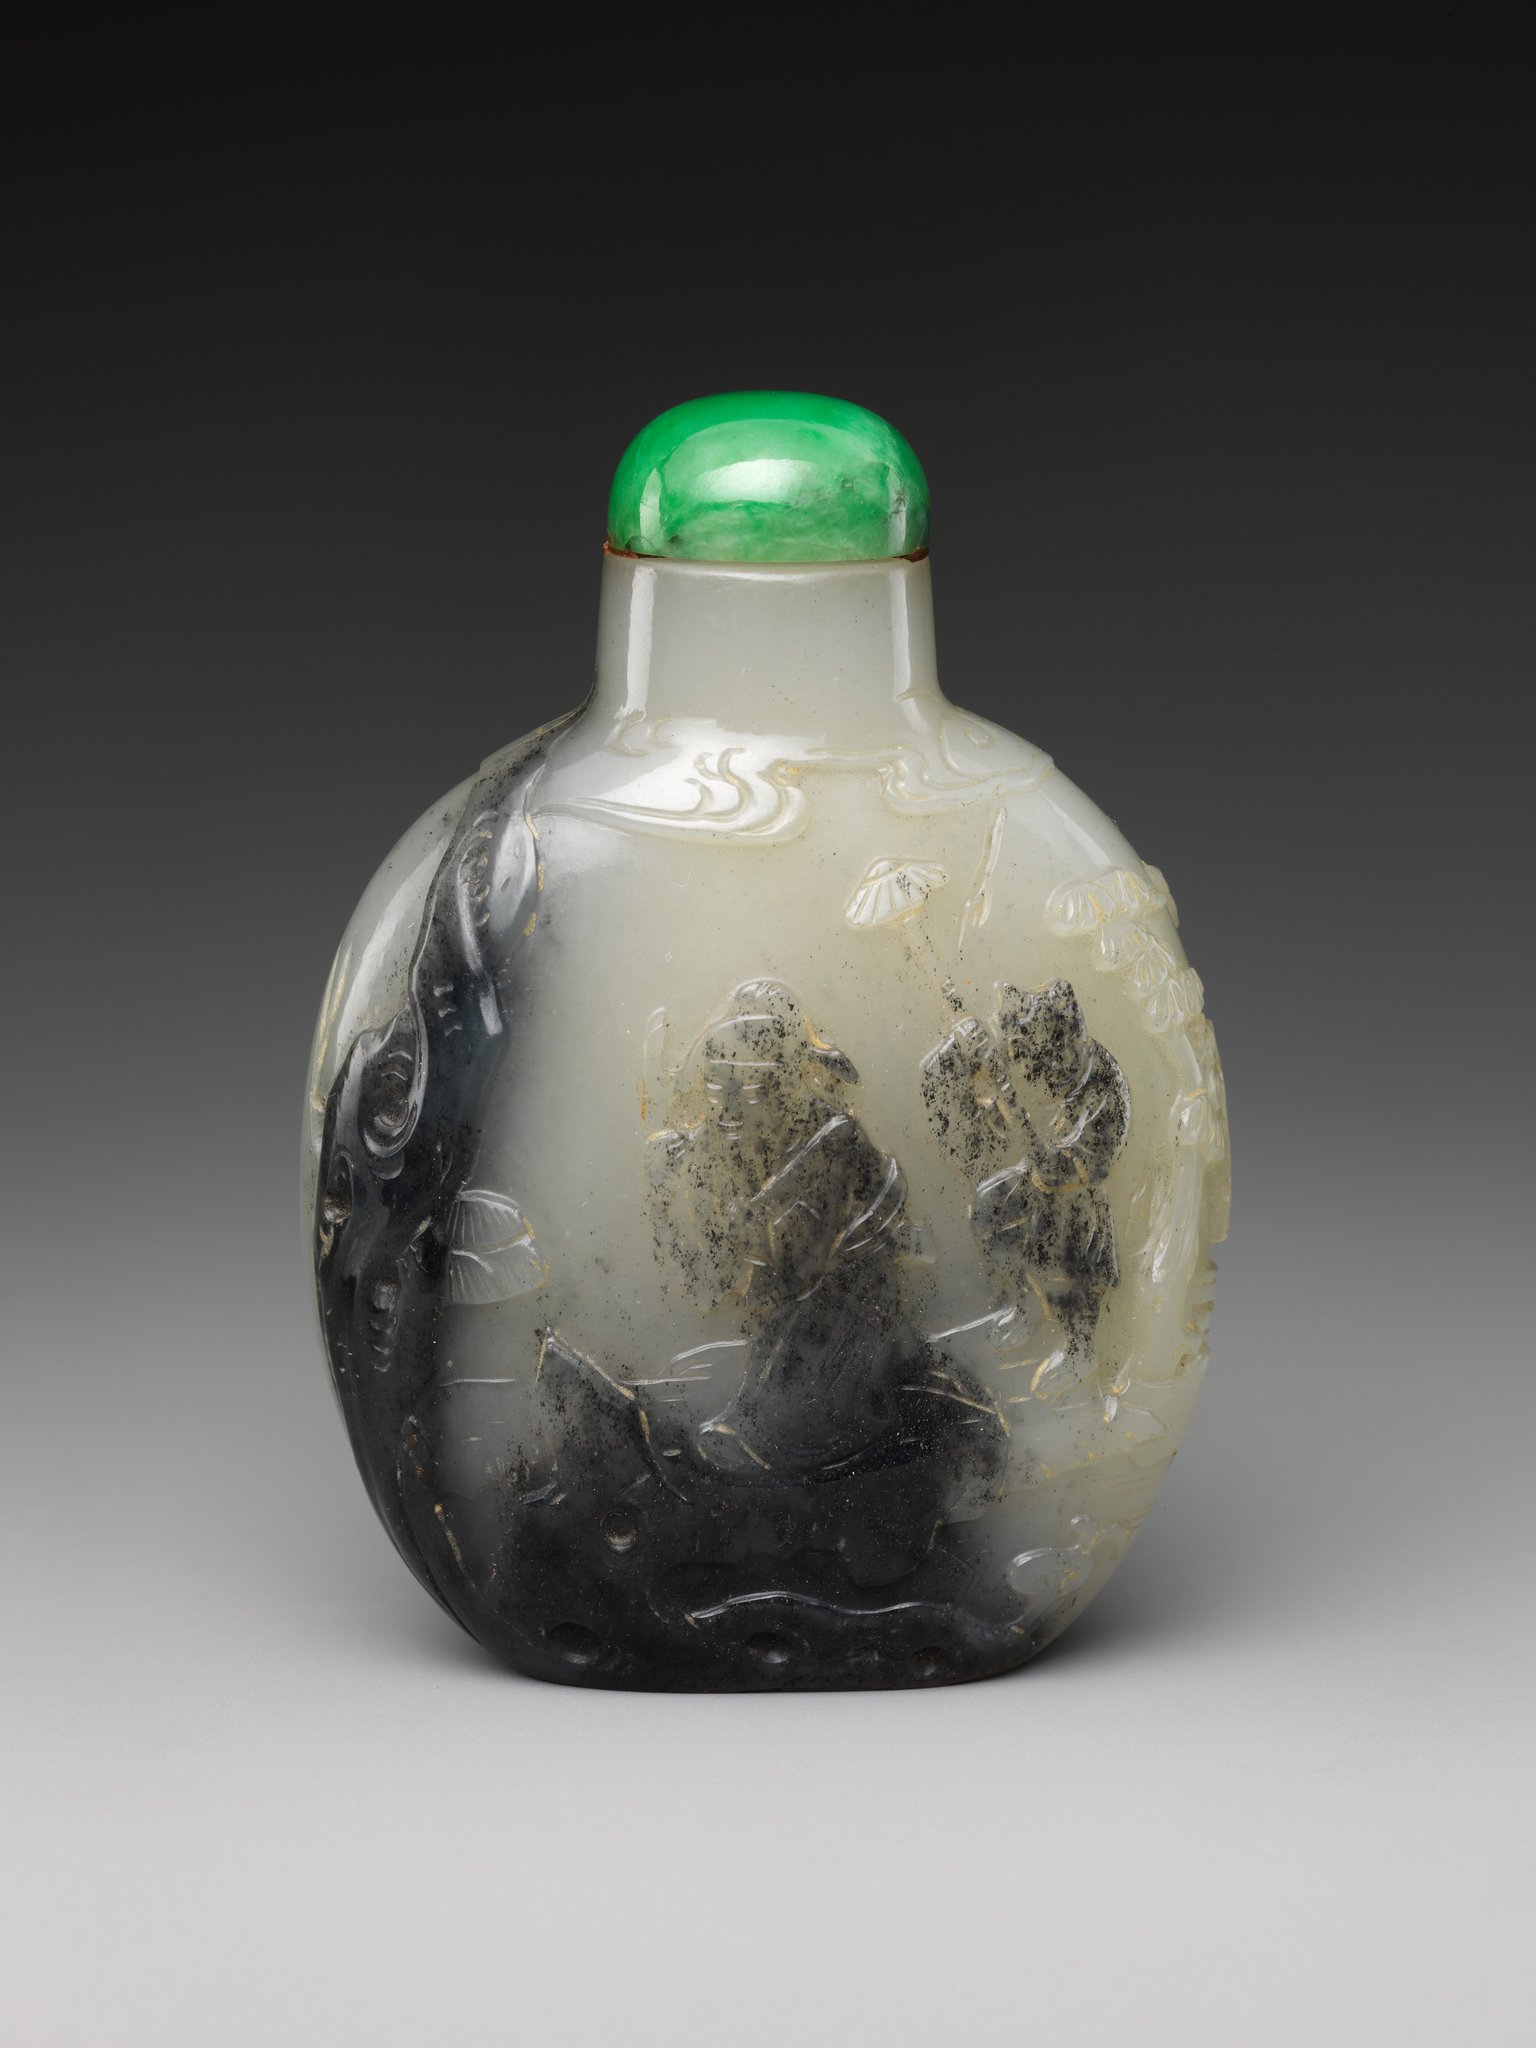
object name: snuff bottle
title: Snuff bottle with Mi Fu bowing to a rock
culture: chinese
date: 1801-1900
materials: jade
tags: men